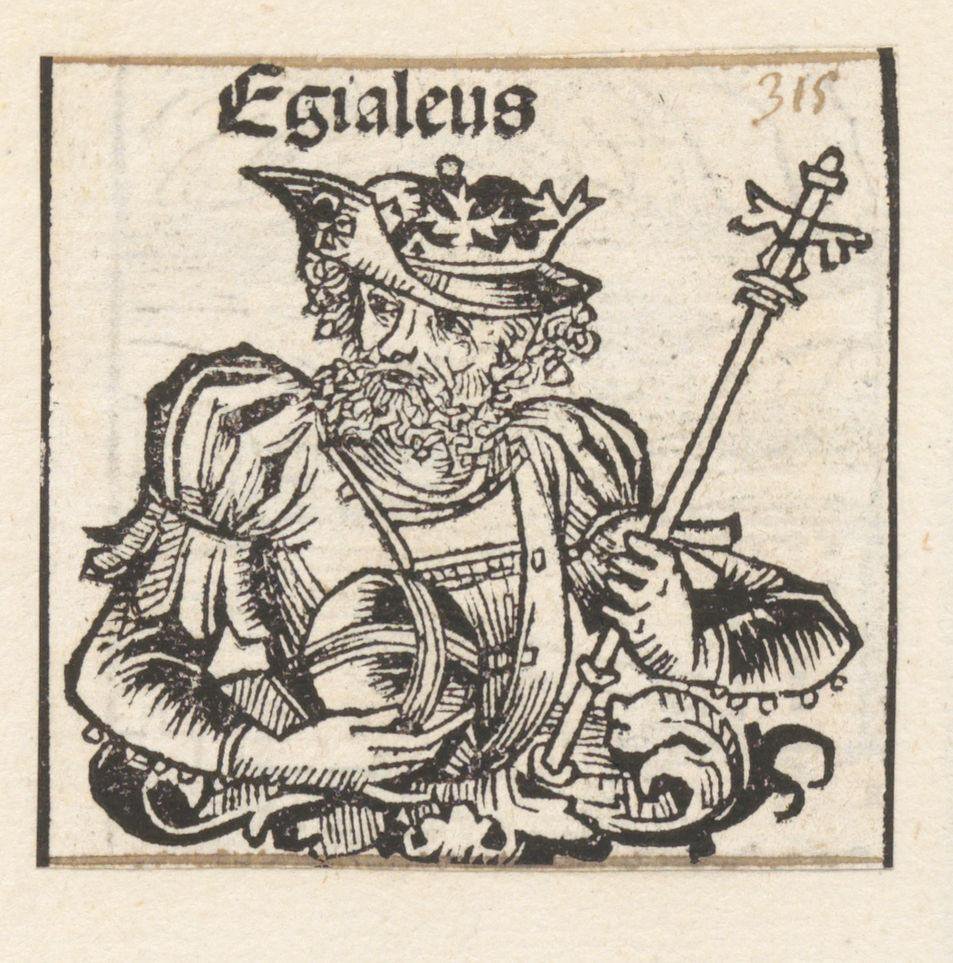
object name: album leaf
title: Koning Aigialeus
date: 1493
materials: paper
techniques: letterpress printing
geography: nuremberg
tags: king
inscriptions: inscription: ‘315’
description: Een bloemkelk met een koning, zijn hoofd naar links gekeerd. Hij heeft een rijksappel en een scepter in zijn handen. De voorstelling is onderdeel van een reeks koningen in de Liber Chronicarum. De tekst identificeert hem als koning Aigialeus, koning van Sicyon. De prent maakt deel uit van een album.